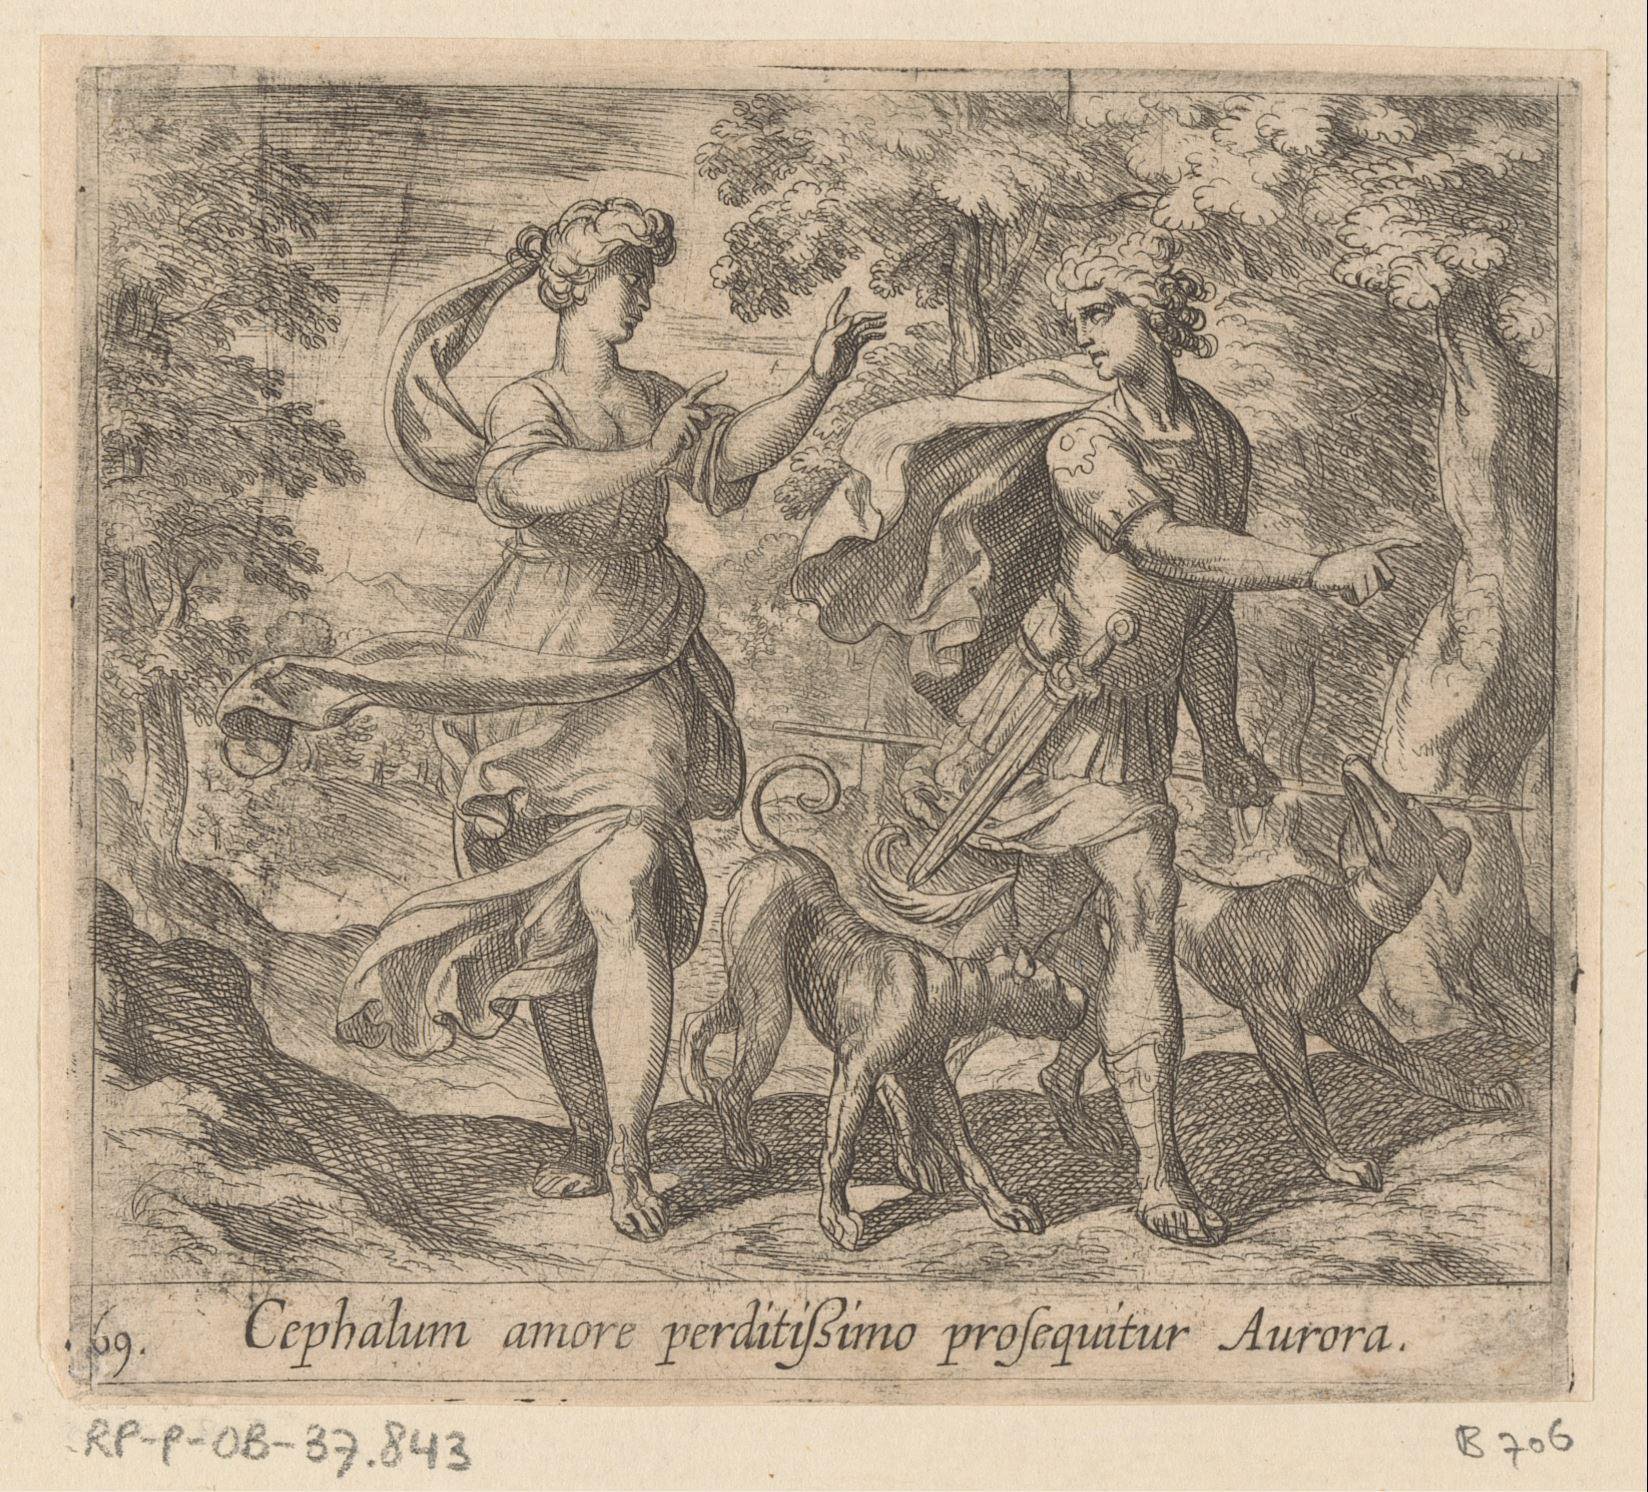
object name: print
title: Metamorphoseon sive transformationum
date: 1606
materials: paper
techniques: etching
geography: italy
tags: cephalus and aurora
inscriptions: collector's mark: Lugt 240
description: Deze prent maakt deel uit van een reeks van 150 prenten (+ titelprent) met voorstellingen van de Metamorfosen van Ovidius.